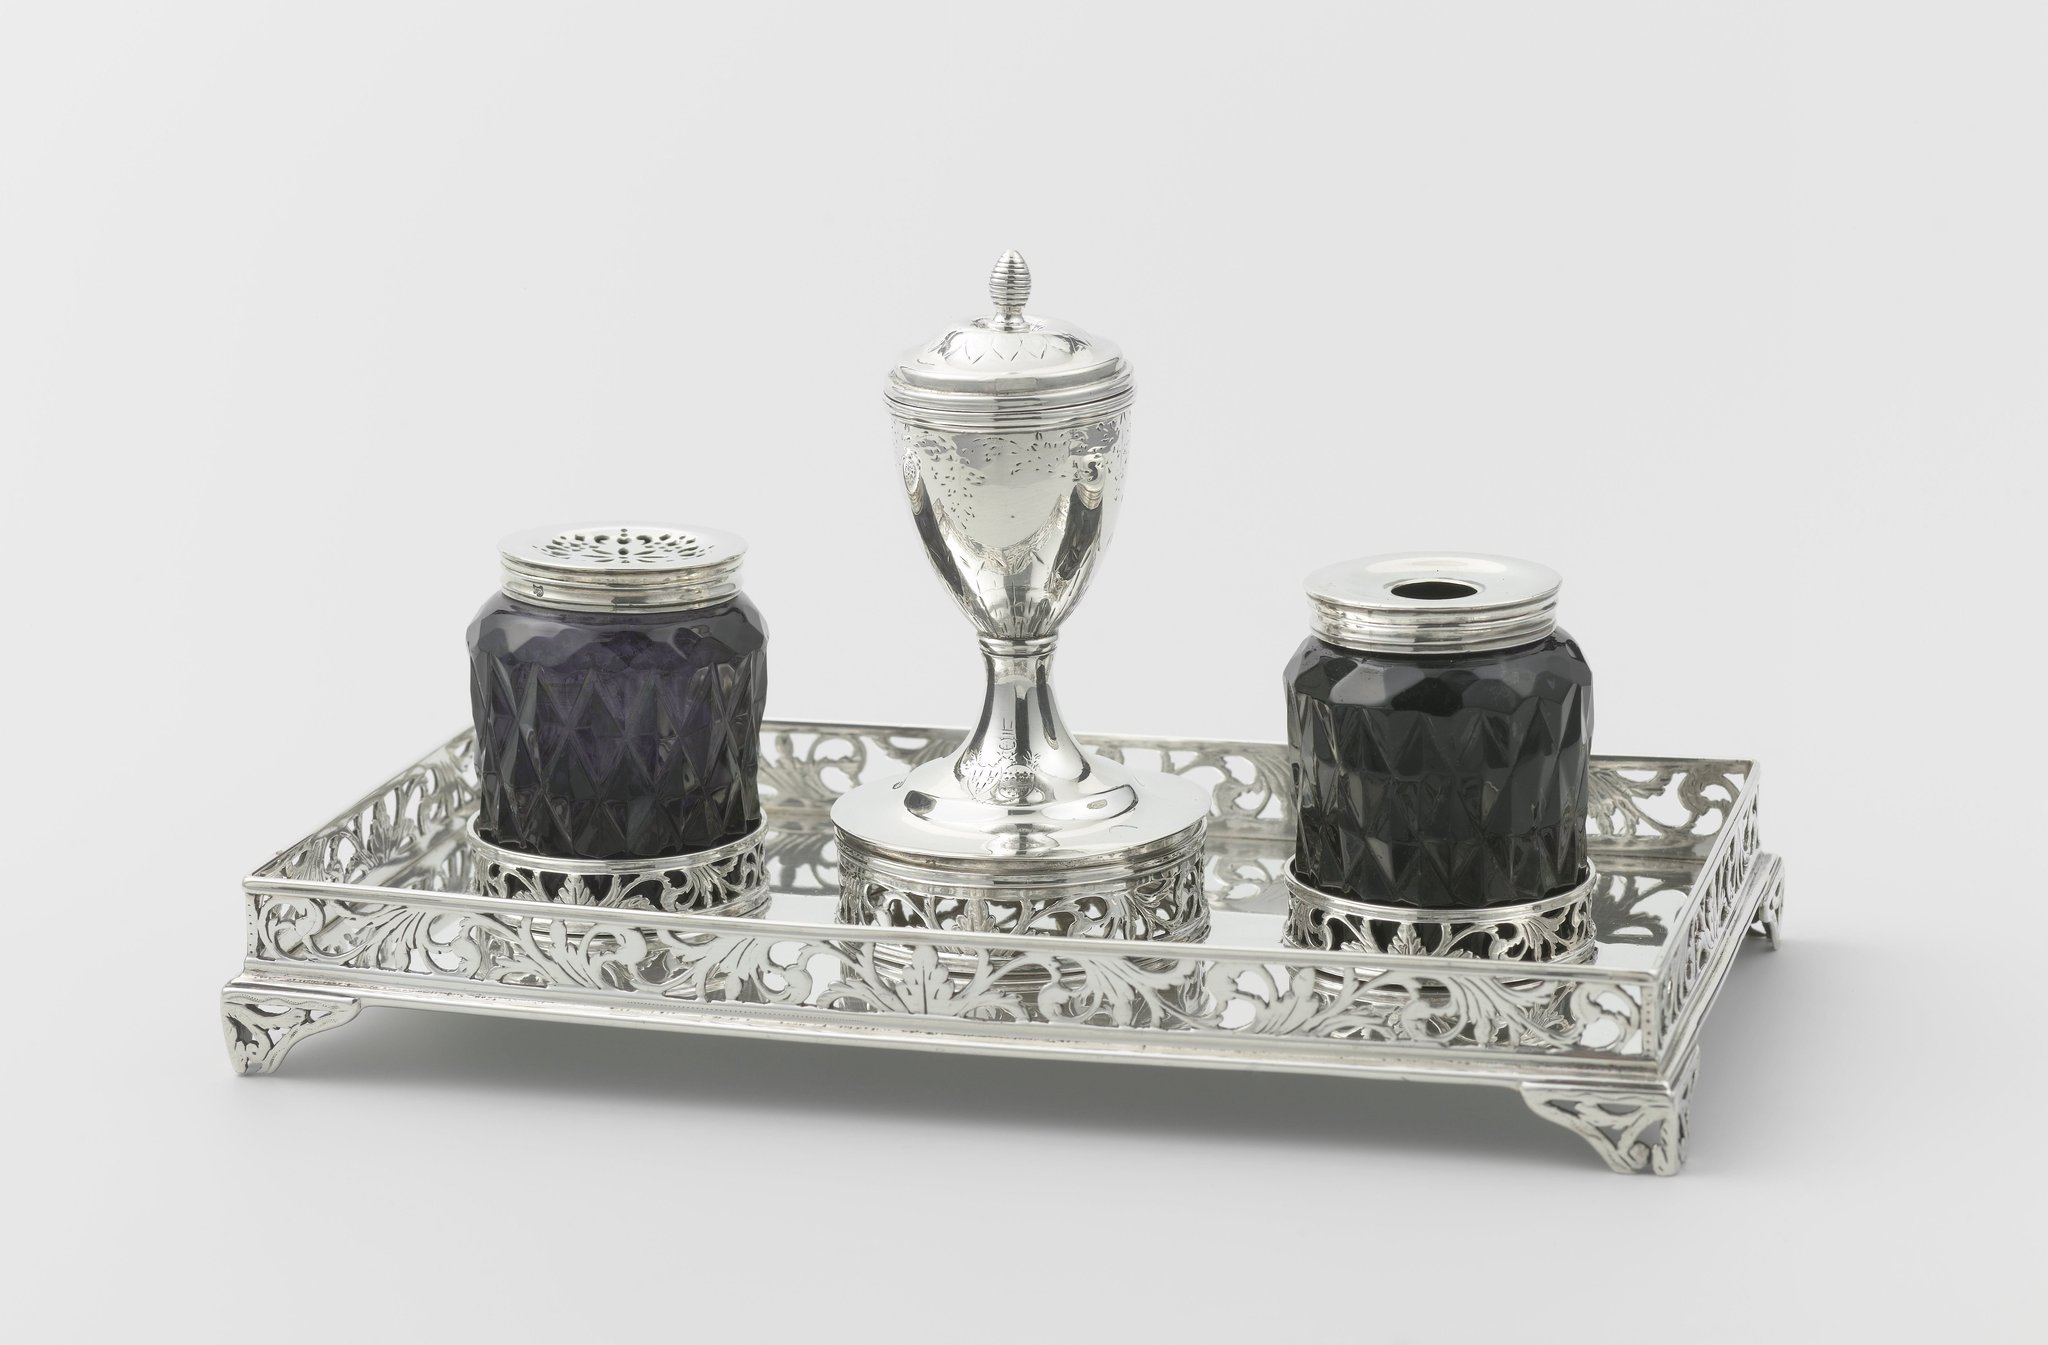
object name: inkstand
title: Inktstel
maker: francois marcus simons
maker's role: silversmith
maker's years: 1750-1828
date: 1802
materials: silver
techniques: casting, engraving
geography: the hague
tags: ornament derived from plant forms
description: Inktstel van zilver, versierd met geciseleerde ranken. Op een rechthoekig blad, rustend op pootjes, zijn drie staande ringen geplaatst. In de middelste past een vaasvormige pennenbak met deksel. In de buitenste twee cilindervormige, facet geslepen flesjes, de inktpot en de zandstrooier. Op de voet van de pennenbak is een wapen gegraveerd. Gemerkt en gedateerd.